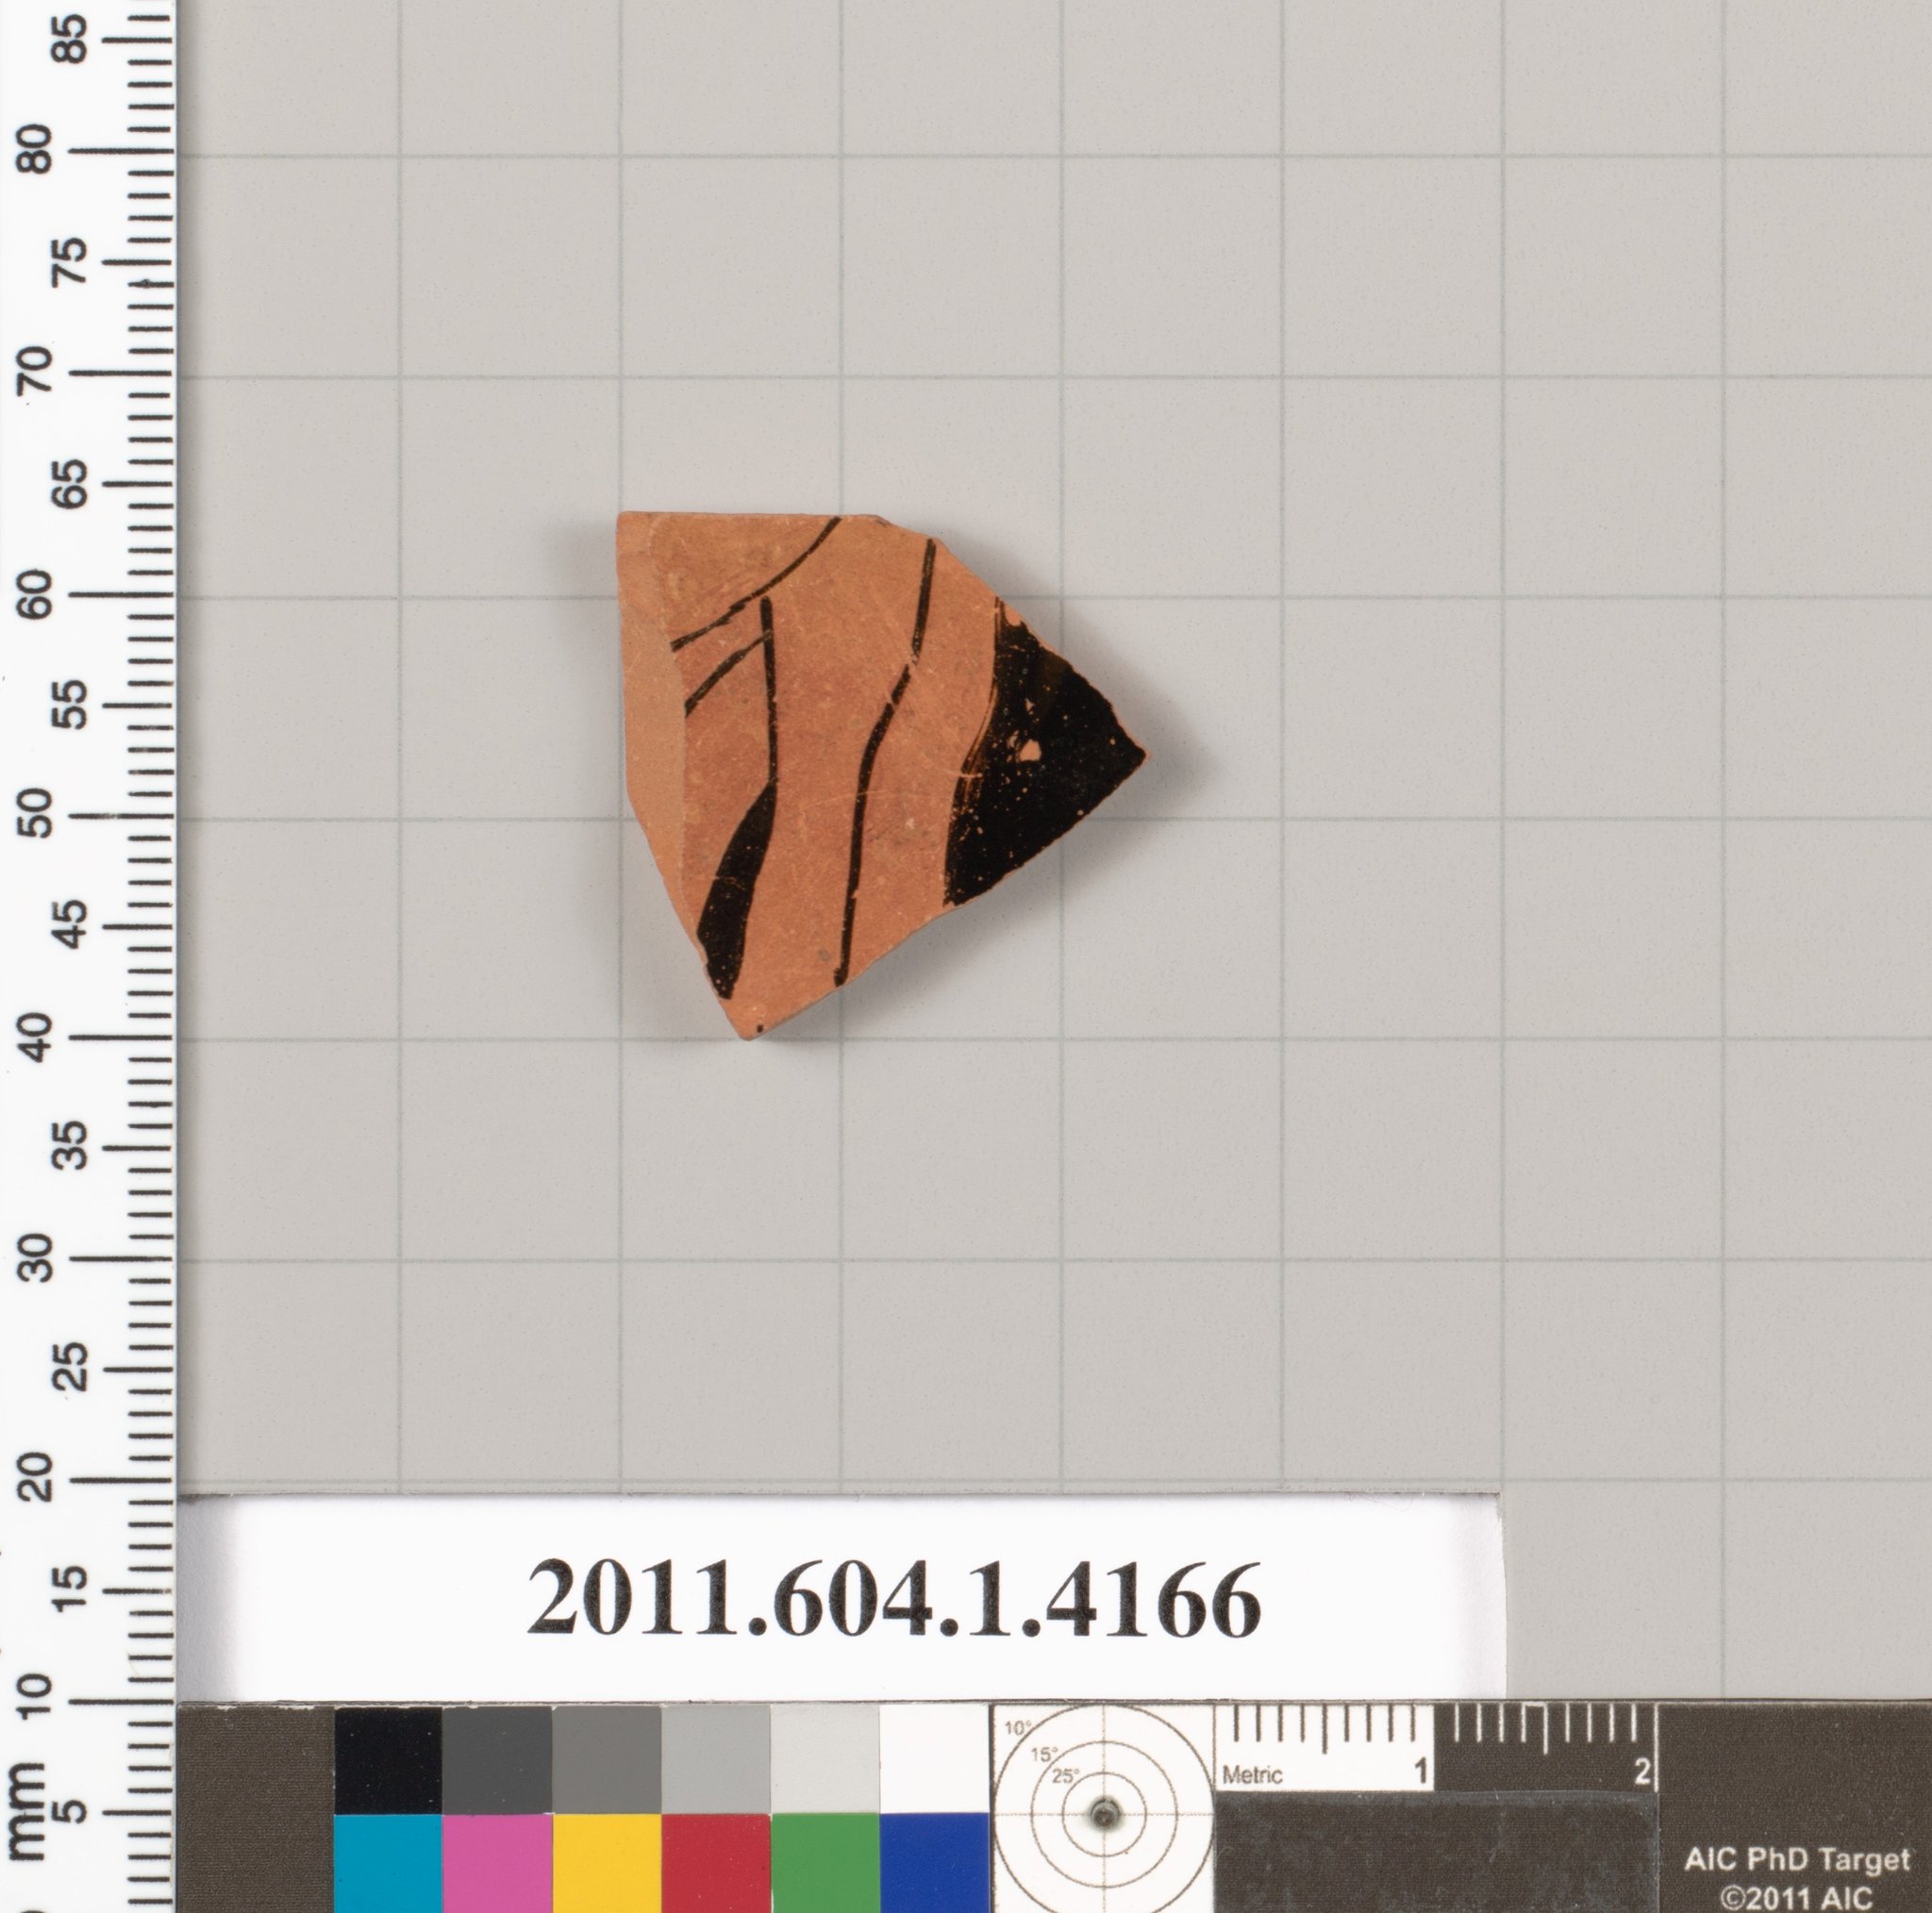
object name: kylix fragment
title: Terracotta fragment of a kylix (drinking cup)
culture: greek, attic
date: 500-480 BCE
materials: terracotta